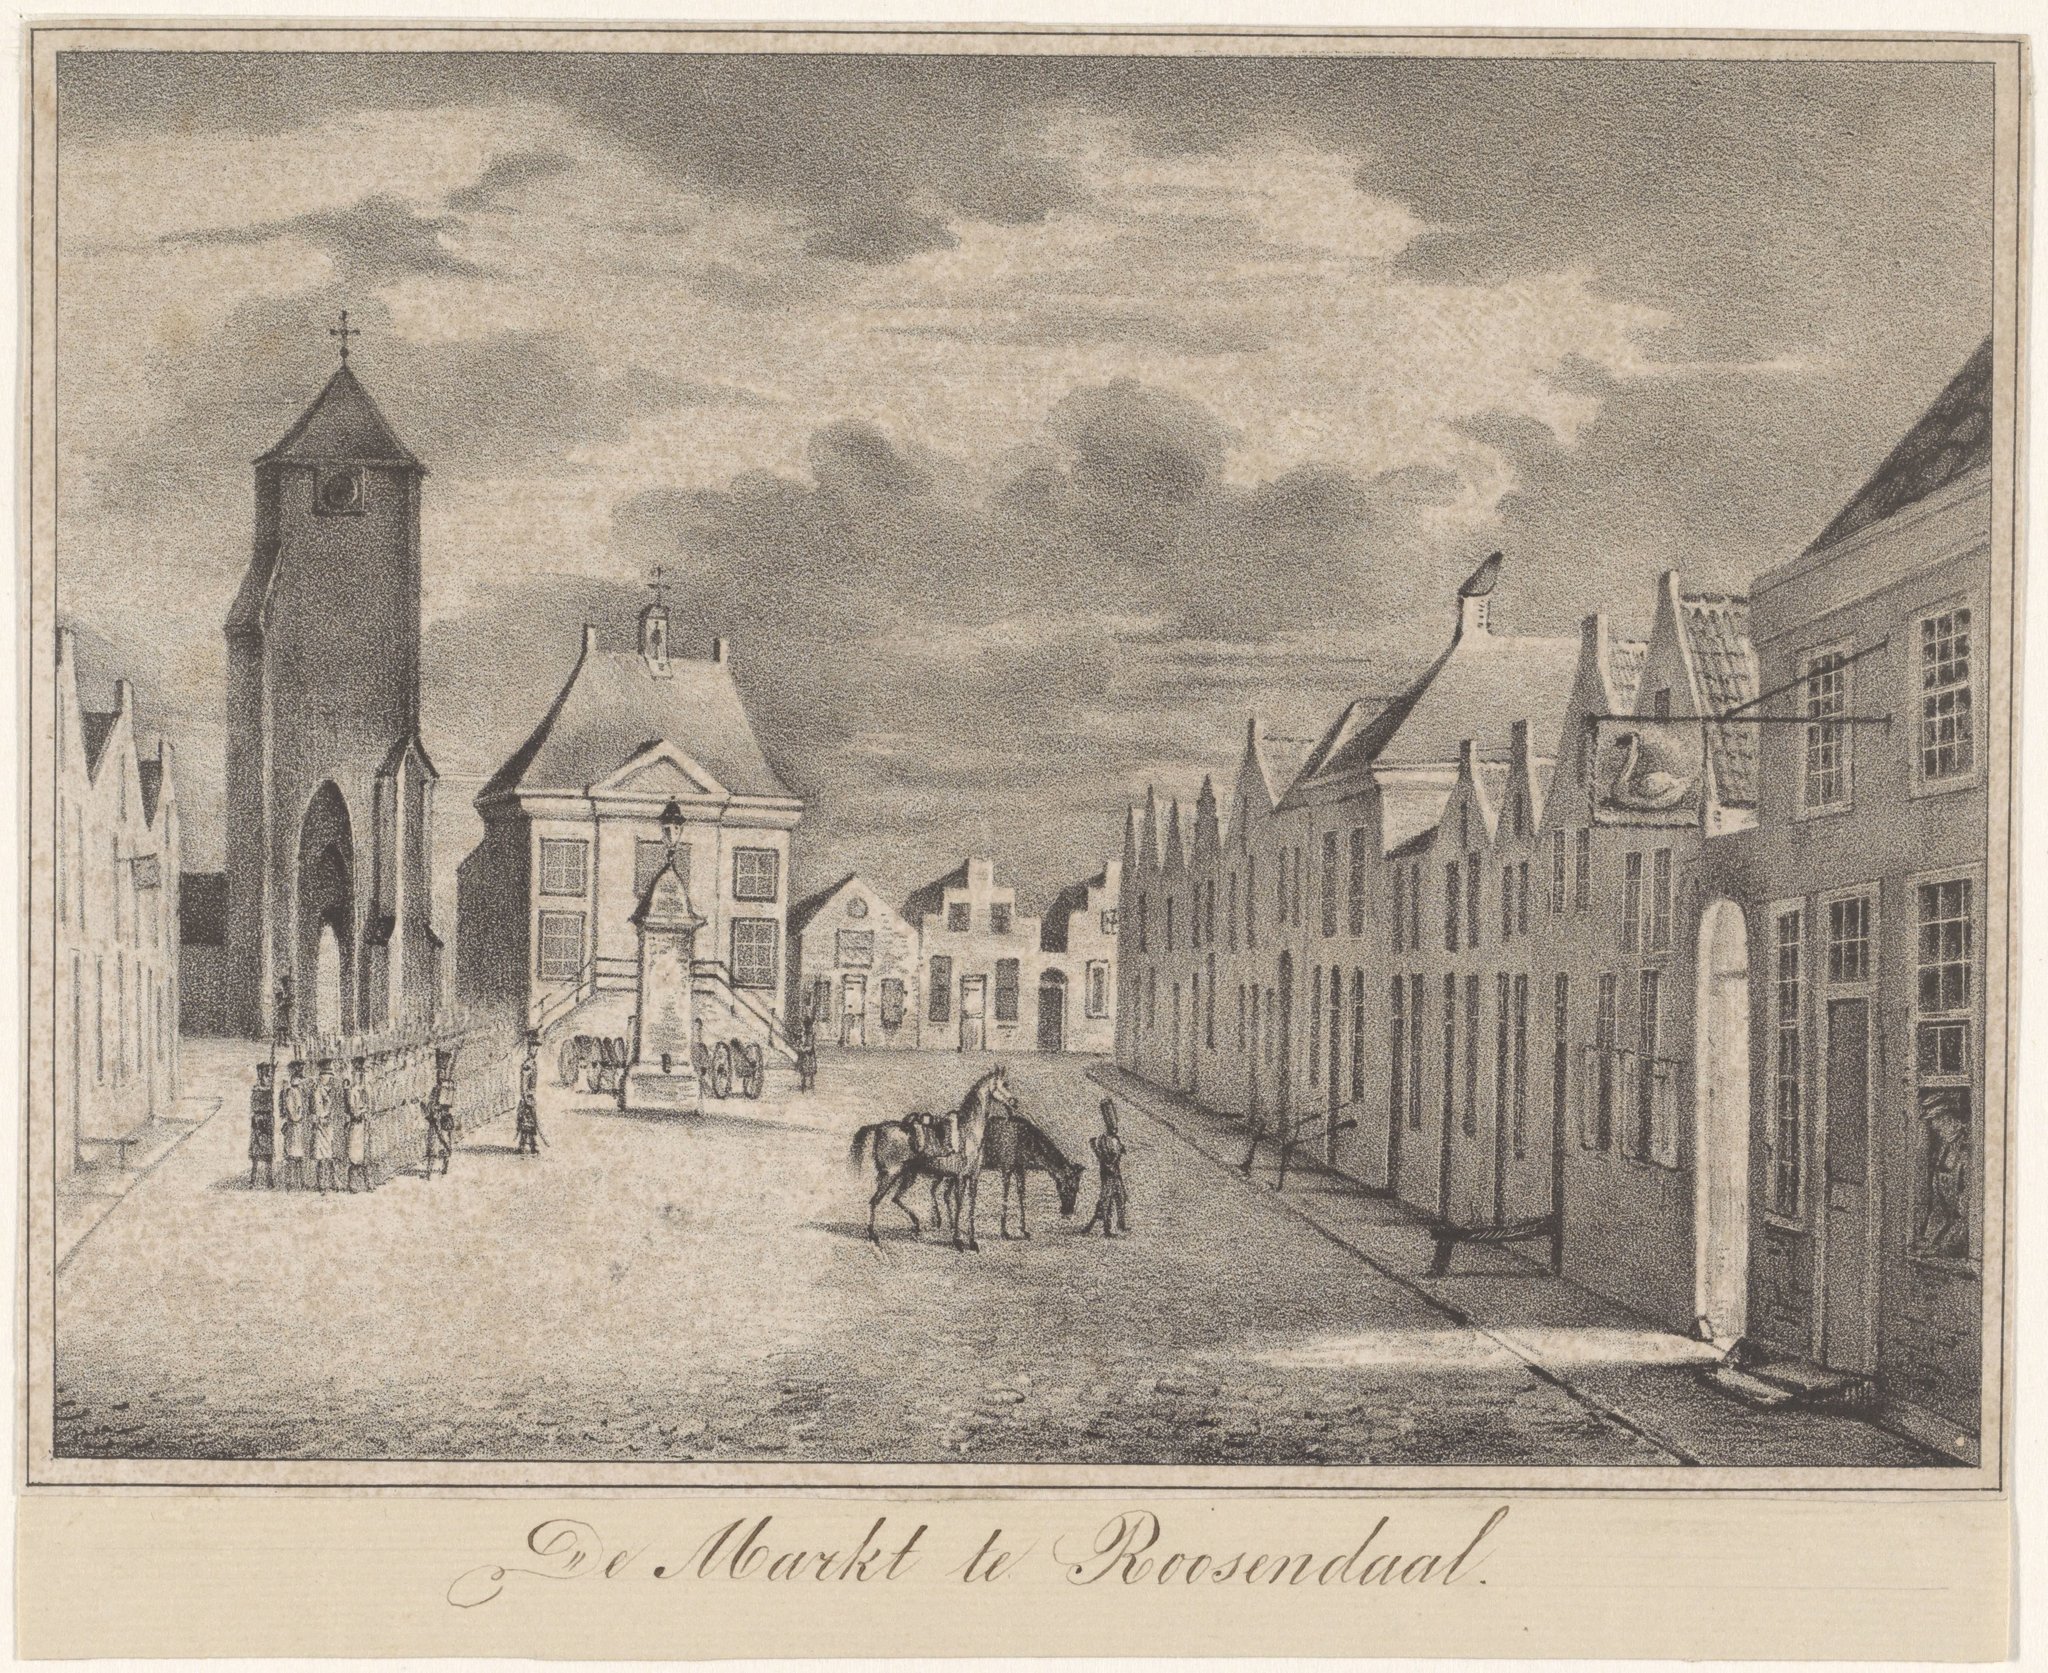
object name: print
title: De Markt te Roosendaal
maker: joannes willem vos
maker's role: print maker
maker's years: 1806-1853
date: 1831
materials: paper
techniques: lithograph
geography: netherlands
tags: shelter ~ military service, guard duty, keeping sentry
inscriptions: caption: ‘De Markt te Roosendaal’, collector's mark: Lugt 2228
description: De vrijwillige schutterij exerceert op de Markt voor het Raadhuis te Roosendaal. Onderdeel van een serie van vijf voorstellingen van de wachthuizen van de Nederlandse schutterij in Noord-Brabant in 1830-1831.